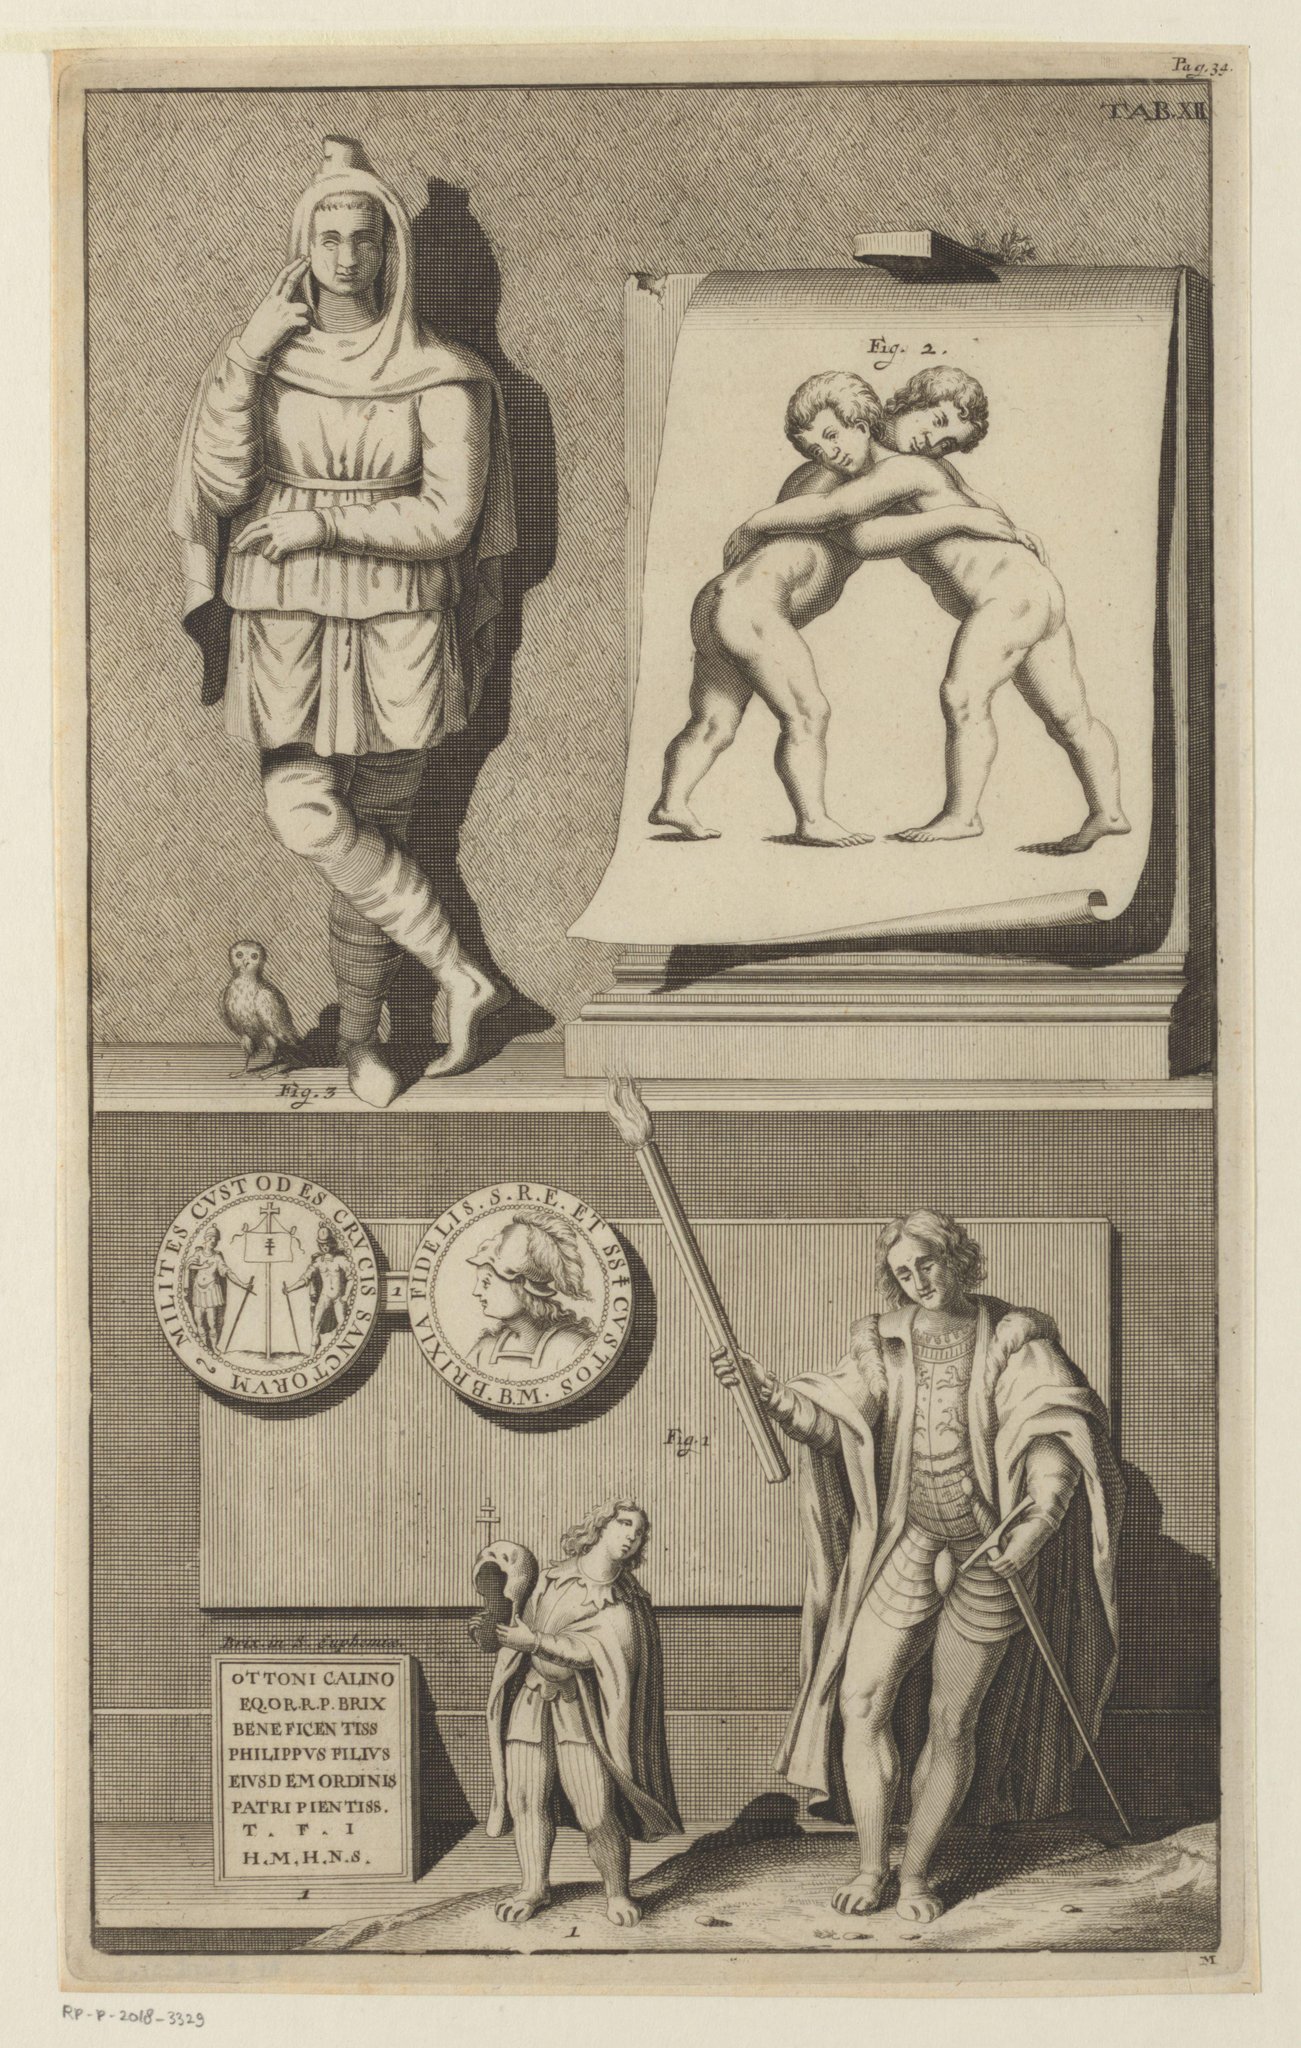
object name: book illustration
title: Compositie met staande man naast een papier met omhelzende jongens boven een edelman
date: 1700-1799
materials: paper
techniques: engraving, etching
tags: embracing each other, kissing, roman religion (including etruscan religion)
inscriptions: collector's mark: Lugt 2228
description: Prent uit een onbekend boek met objecten, kunstwerken en figuren uit de Romeinse geschiedenis en religie. Dit betreft een illustratie bij p. 34.